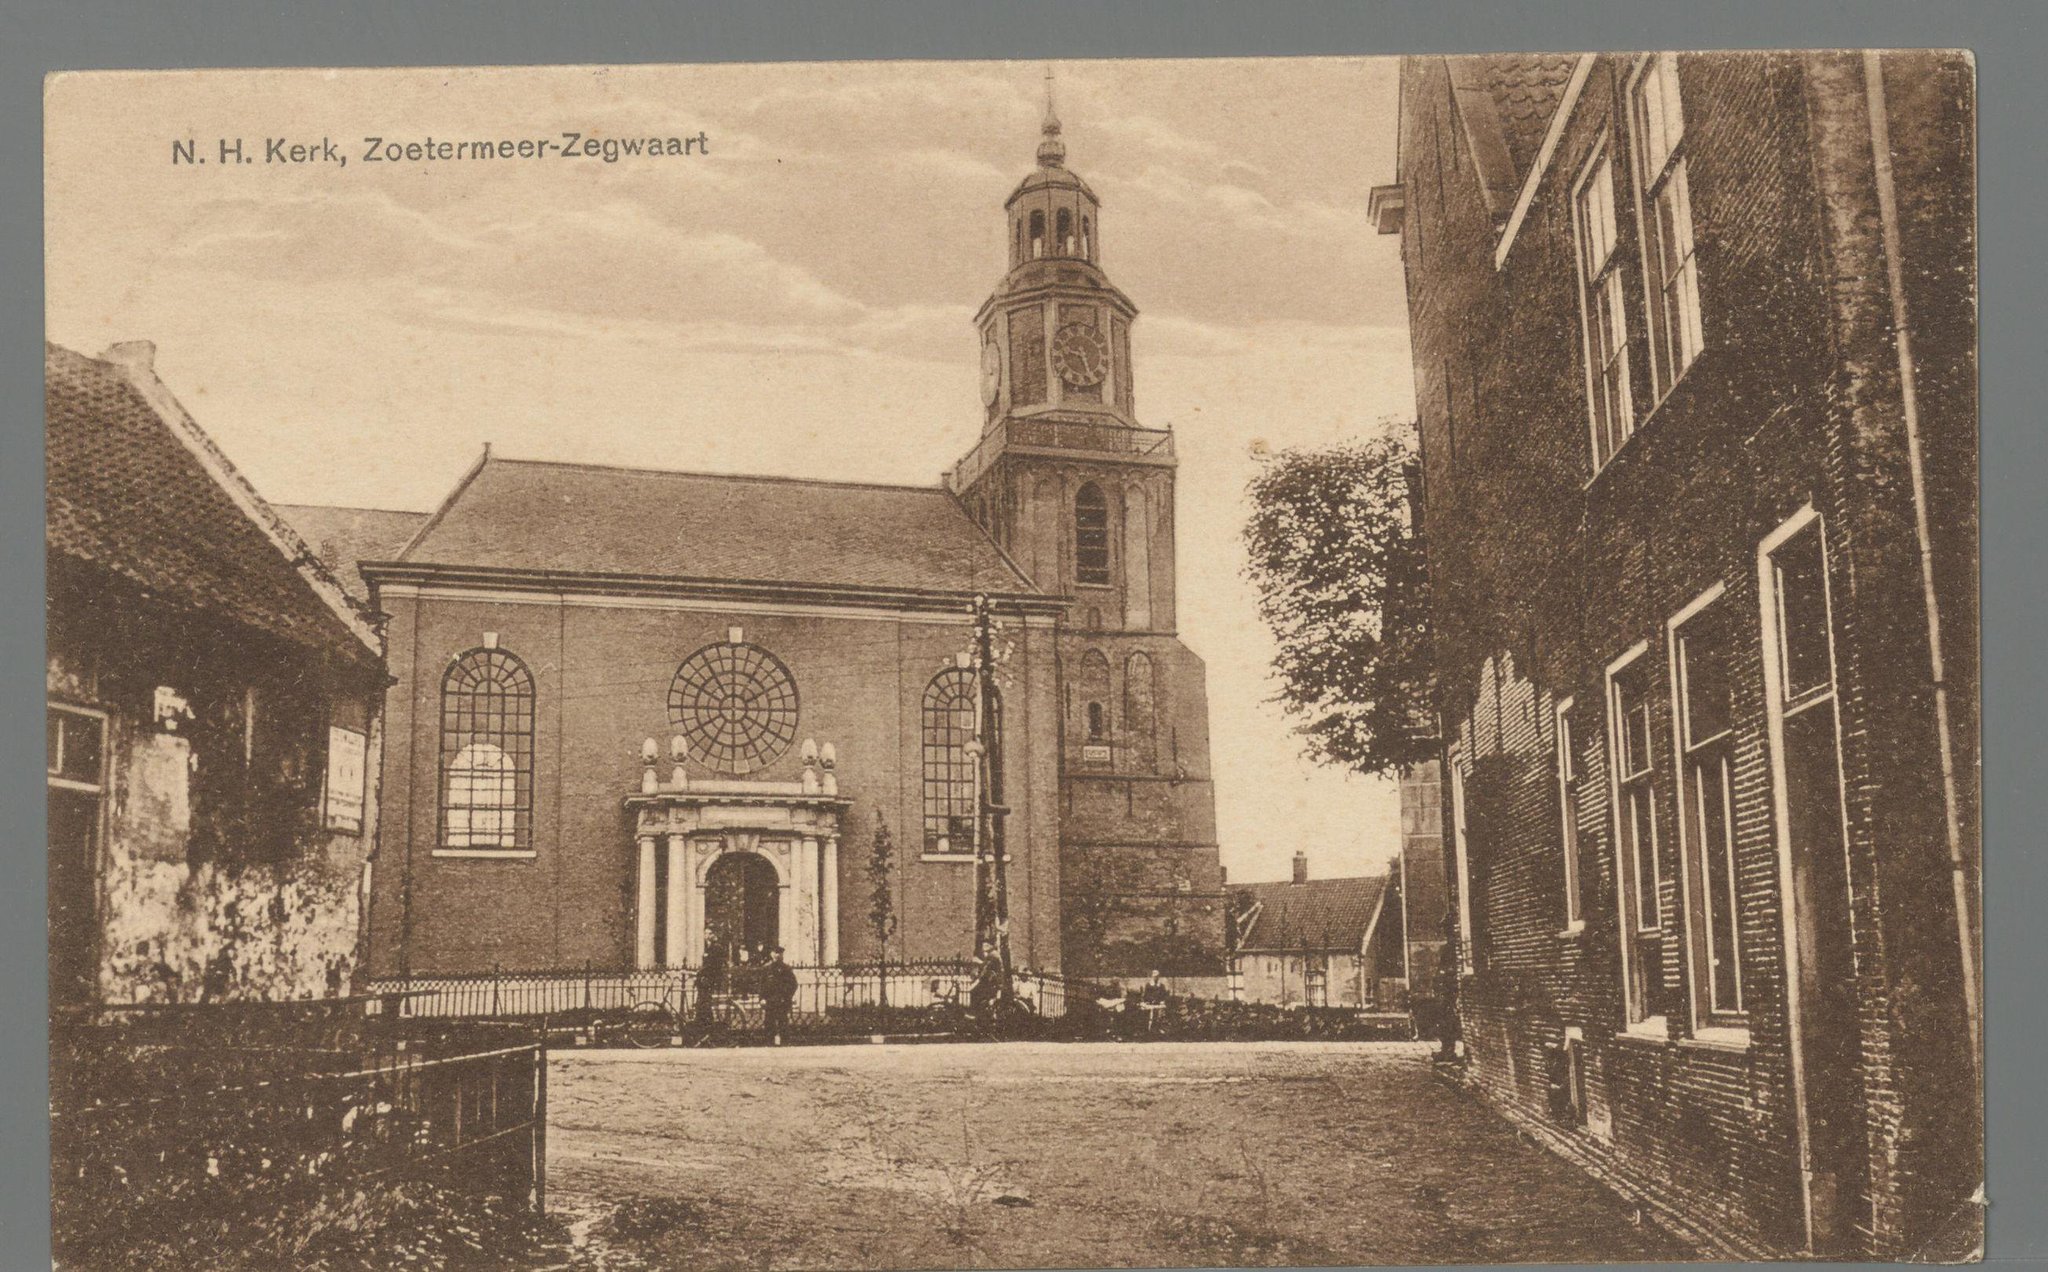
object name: photomechanical print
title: N.H. Kerk, Zoetermeer-Zegwaart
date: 1926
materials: cardboard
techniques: photograph, writing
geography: zoetermeer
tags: church (exterior)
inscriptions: postage stamp